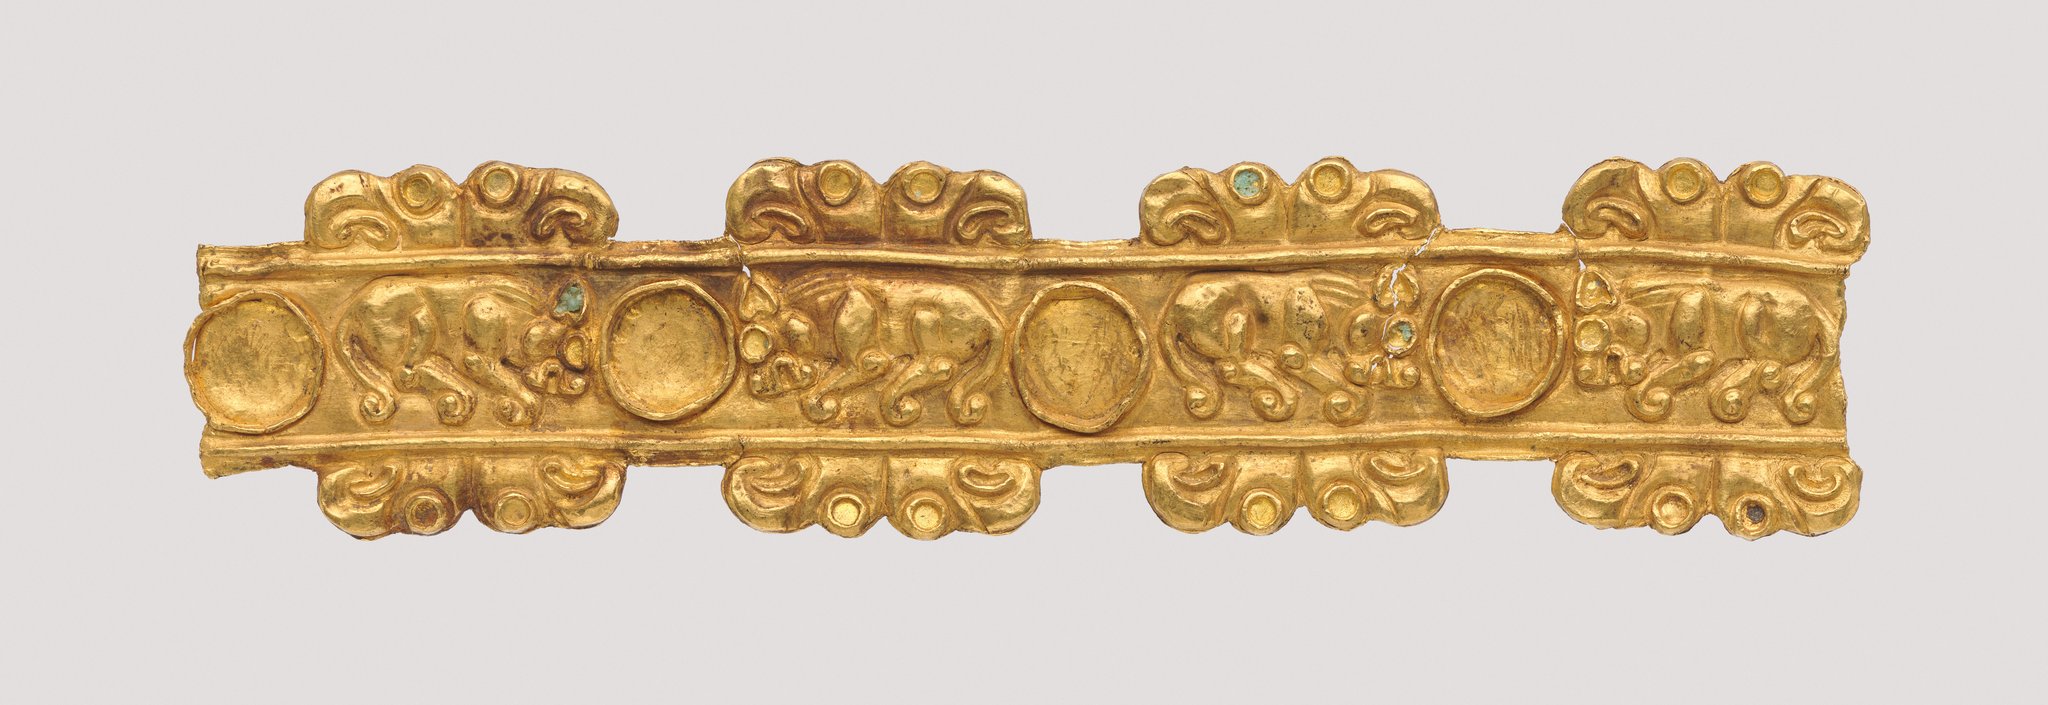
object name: relief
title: Section of a band with felines and heads of birds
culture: iranian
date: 700-601 BCE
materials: glass, gold, paste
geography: iran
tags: ibex